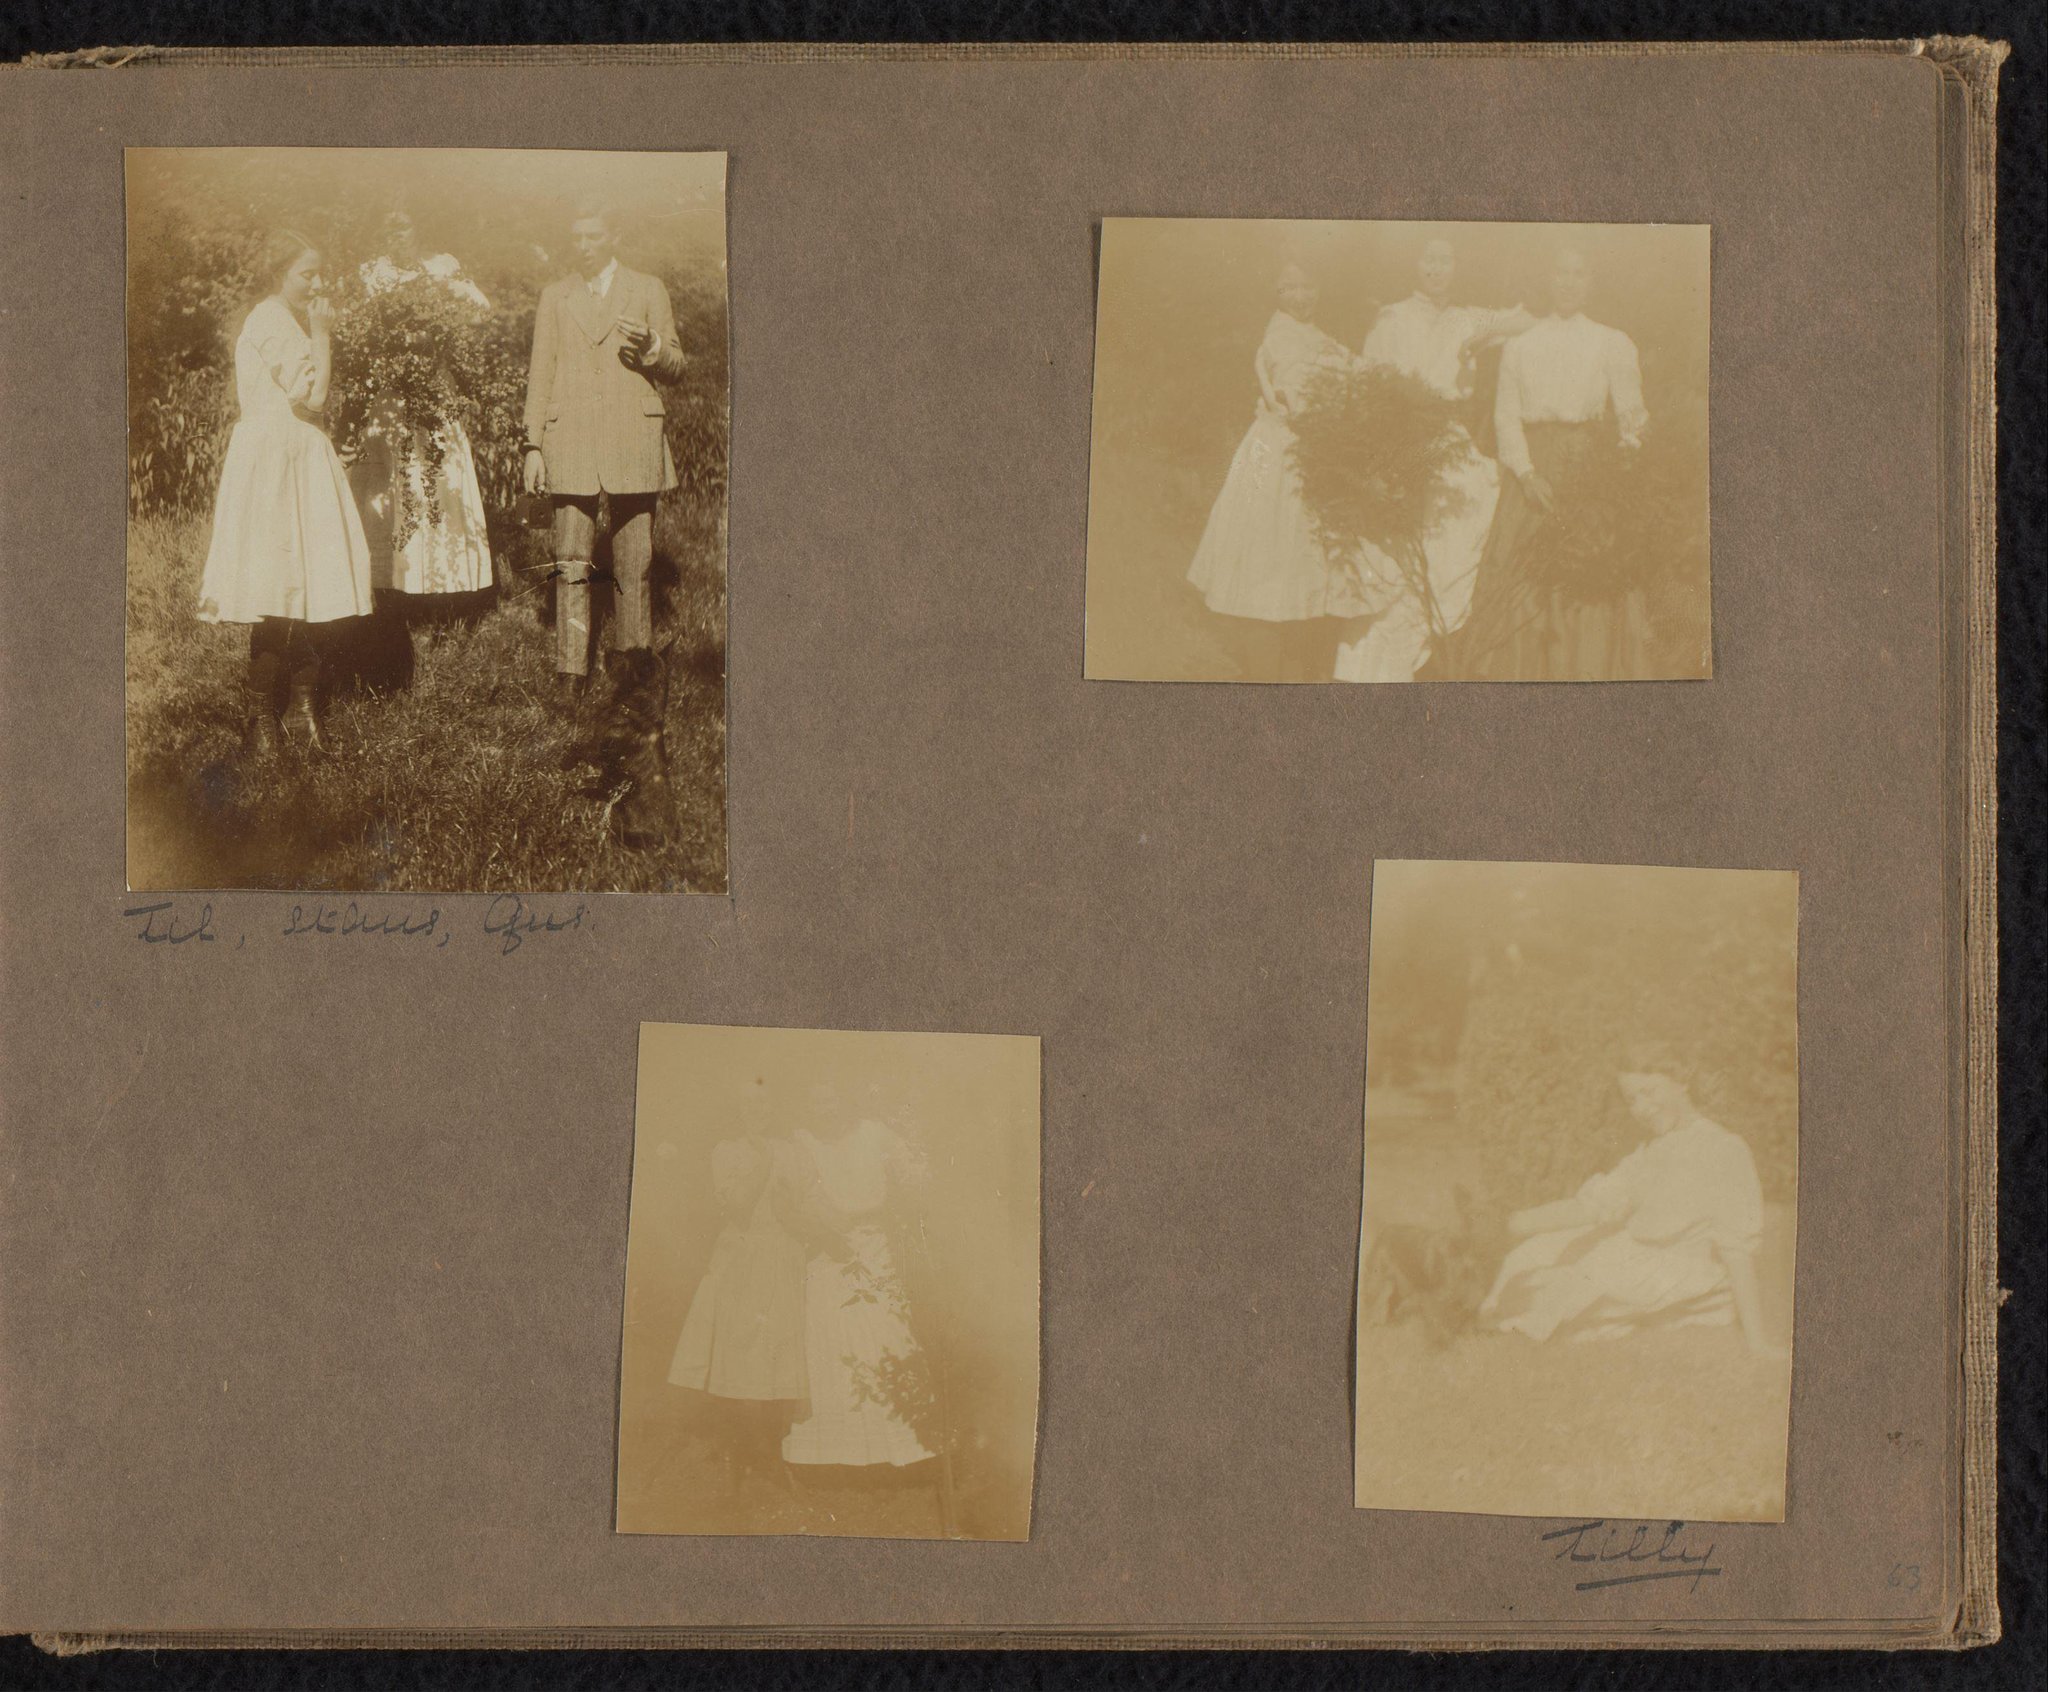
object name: photograph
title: Vier foto's van vrienden van Loentje Onnen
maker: carolina frederika onnen (lien/loen)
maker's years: 1896-1983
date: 1910-1911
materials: paper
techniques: gelatin silver print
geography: hilversum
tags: friends, historical persons not known by name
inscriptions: inscription: ‘Til, Stans, Gus’, inscription: ‘Tilly’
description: Deze foto's maken deel uit van een album.